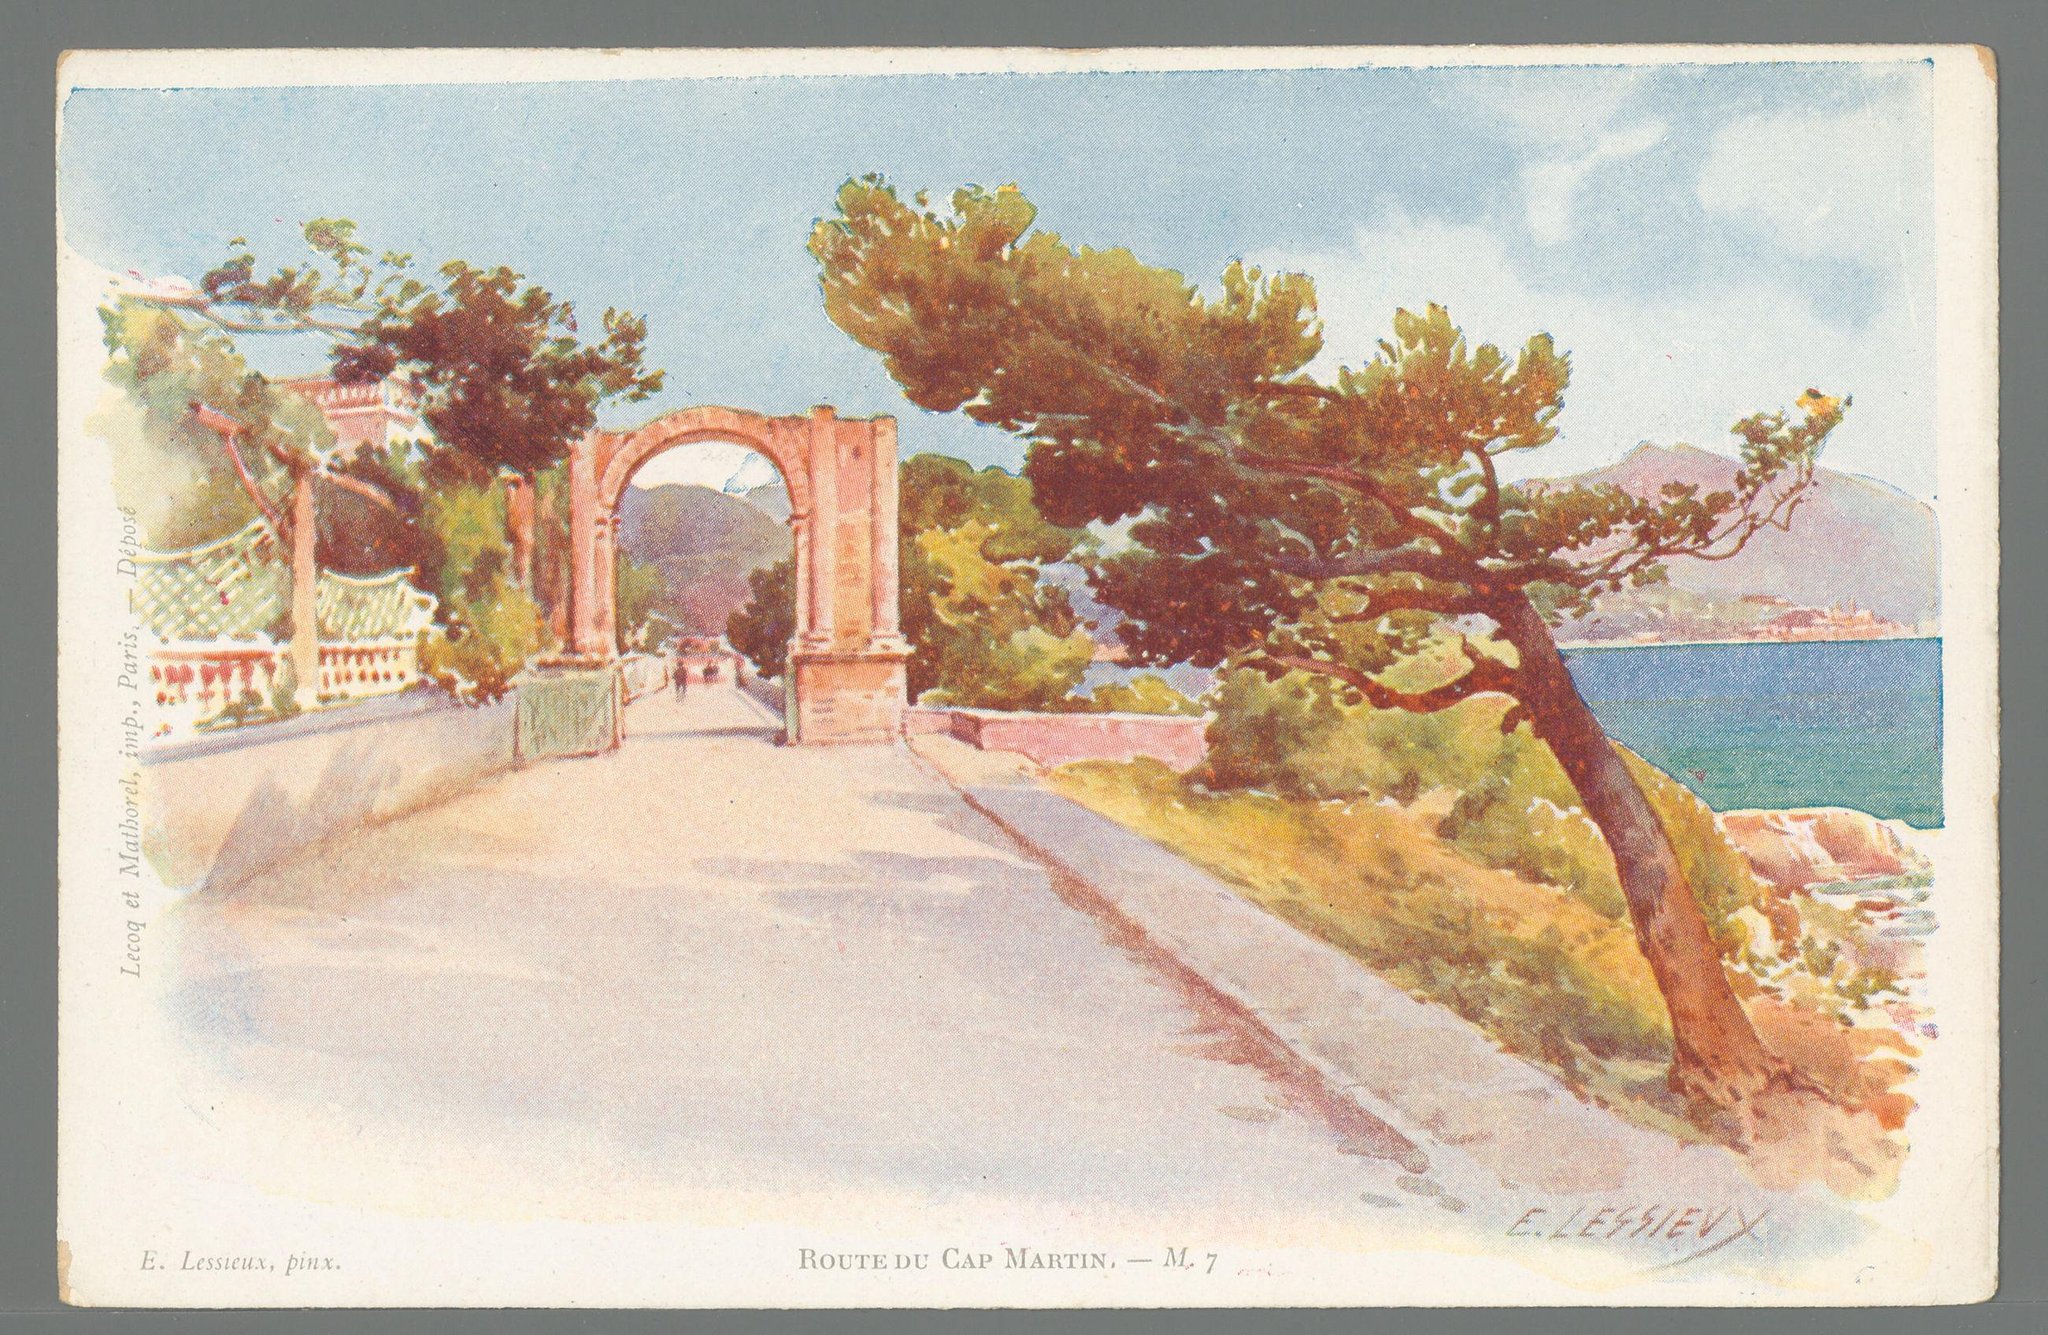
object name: photomechanical print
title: Route du Cap Martin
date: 1892-1904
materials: cardboard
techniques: writing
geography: paris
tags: avenue, boulevard, promenade, esplanade, coast